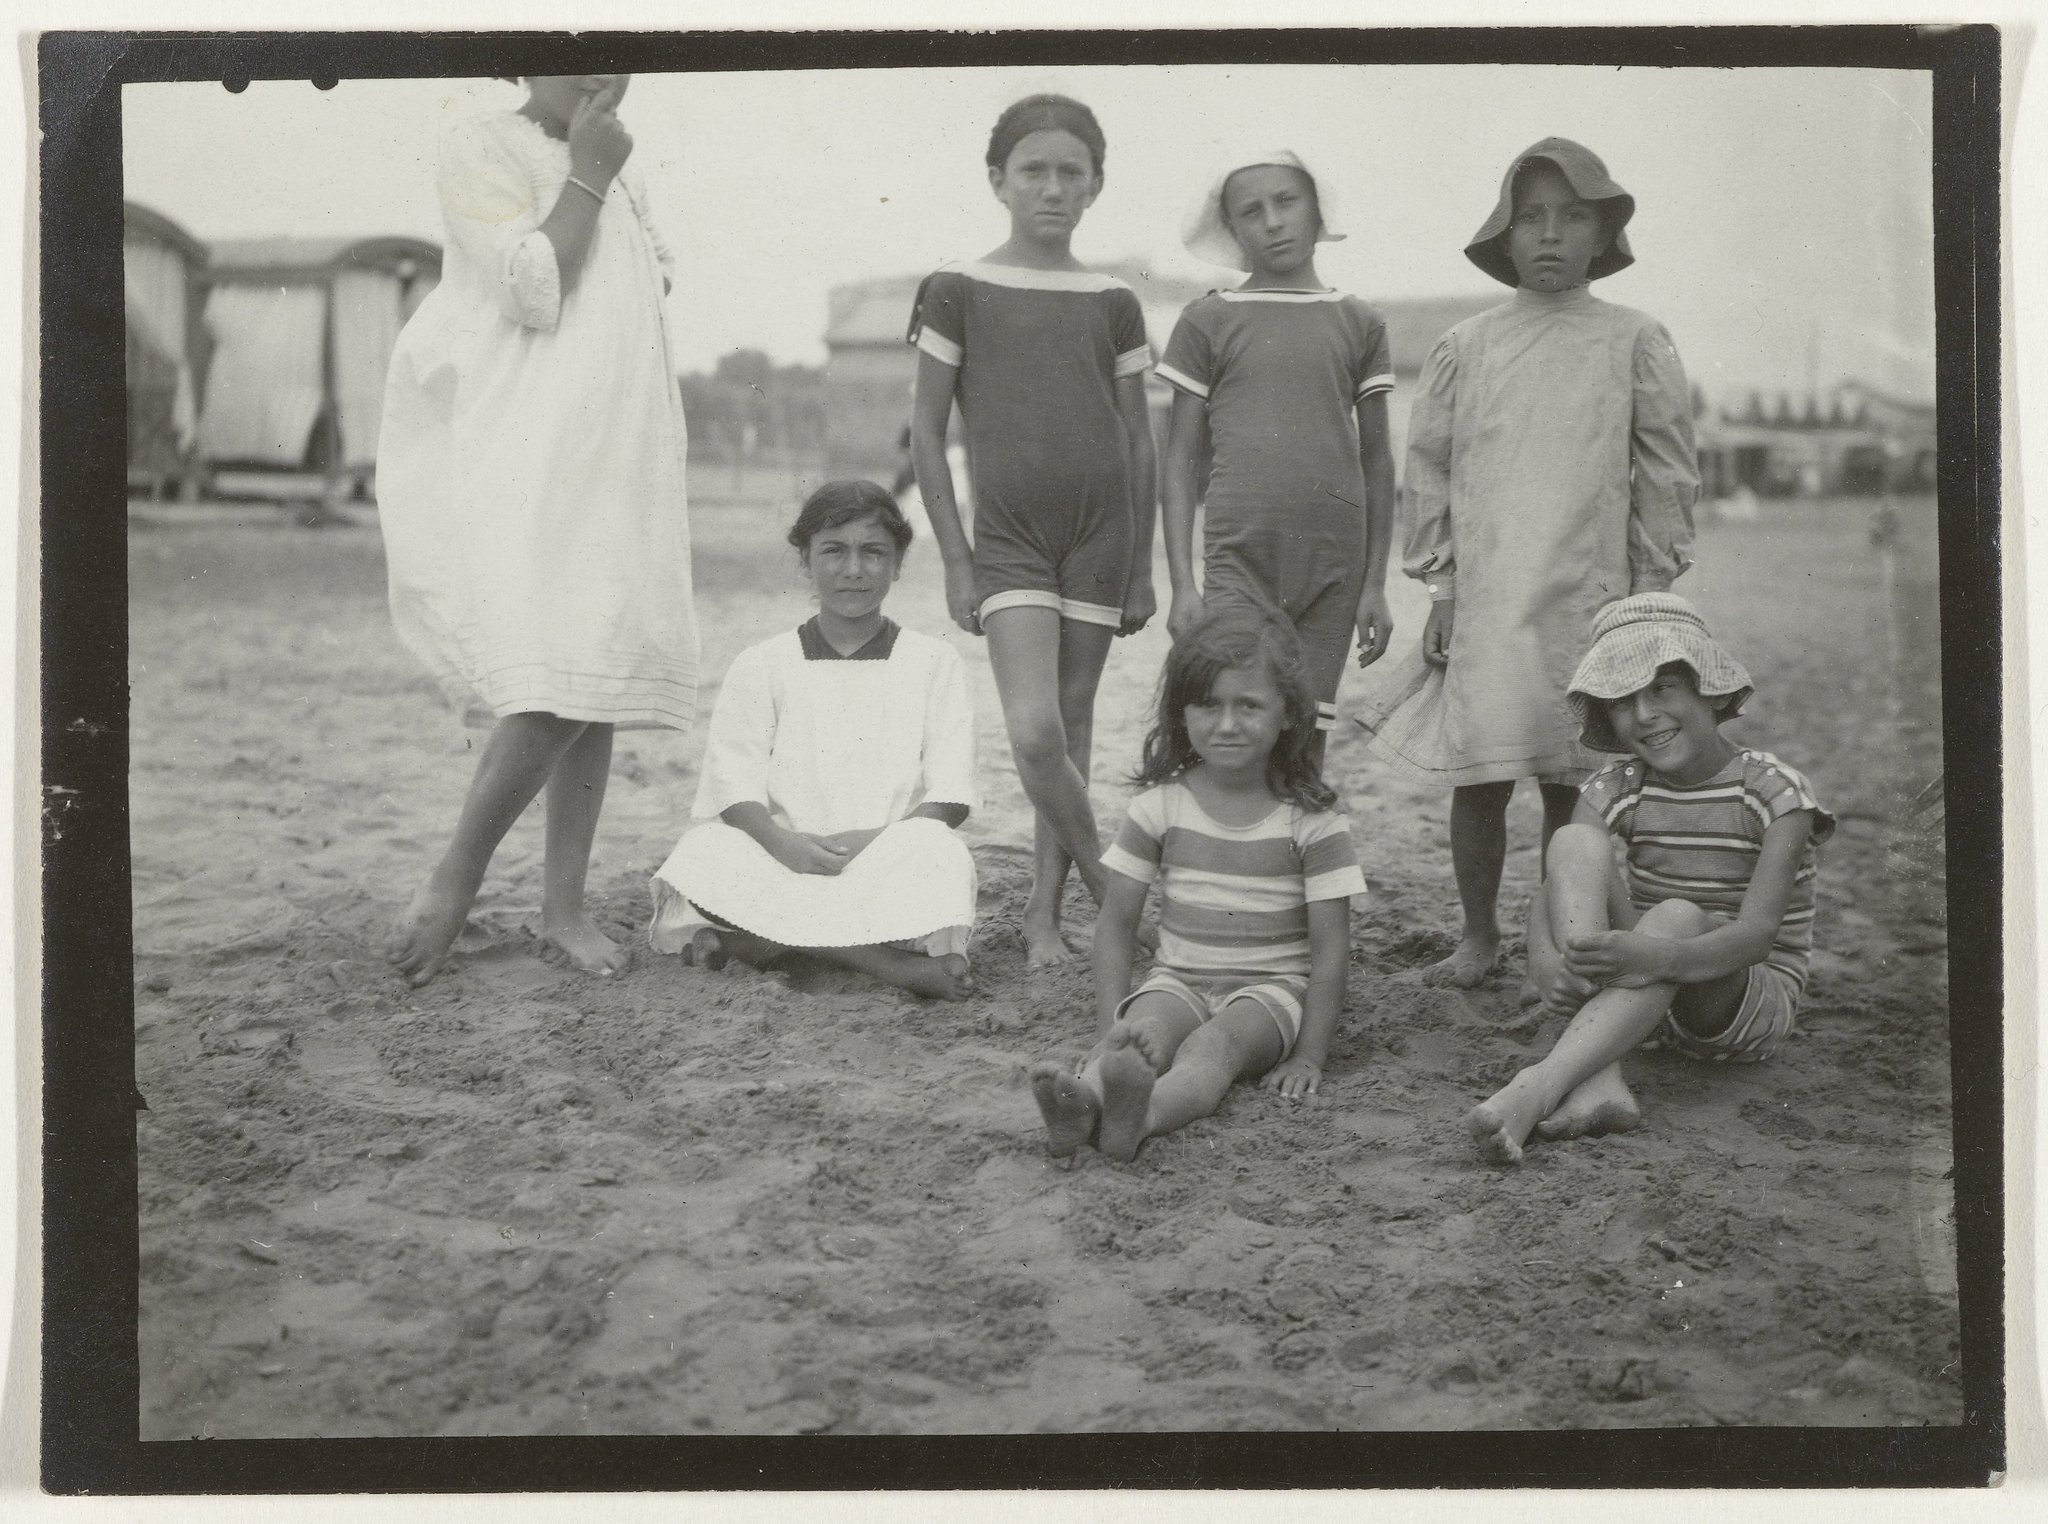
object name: photograph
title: Groepsportret van zeven kinderen op het strand (Noordzeekust), Nederland of Duitsland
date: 1900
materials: paper, photographic support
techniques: gelatin silver print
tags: beach (as place of recreation), netherlands, germany